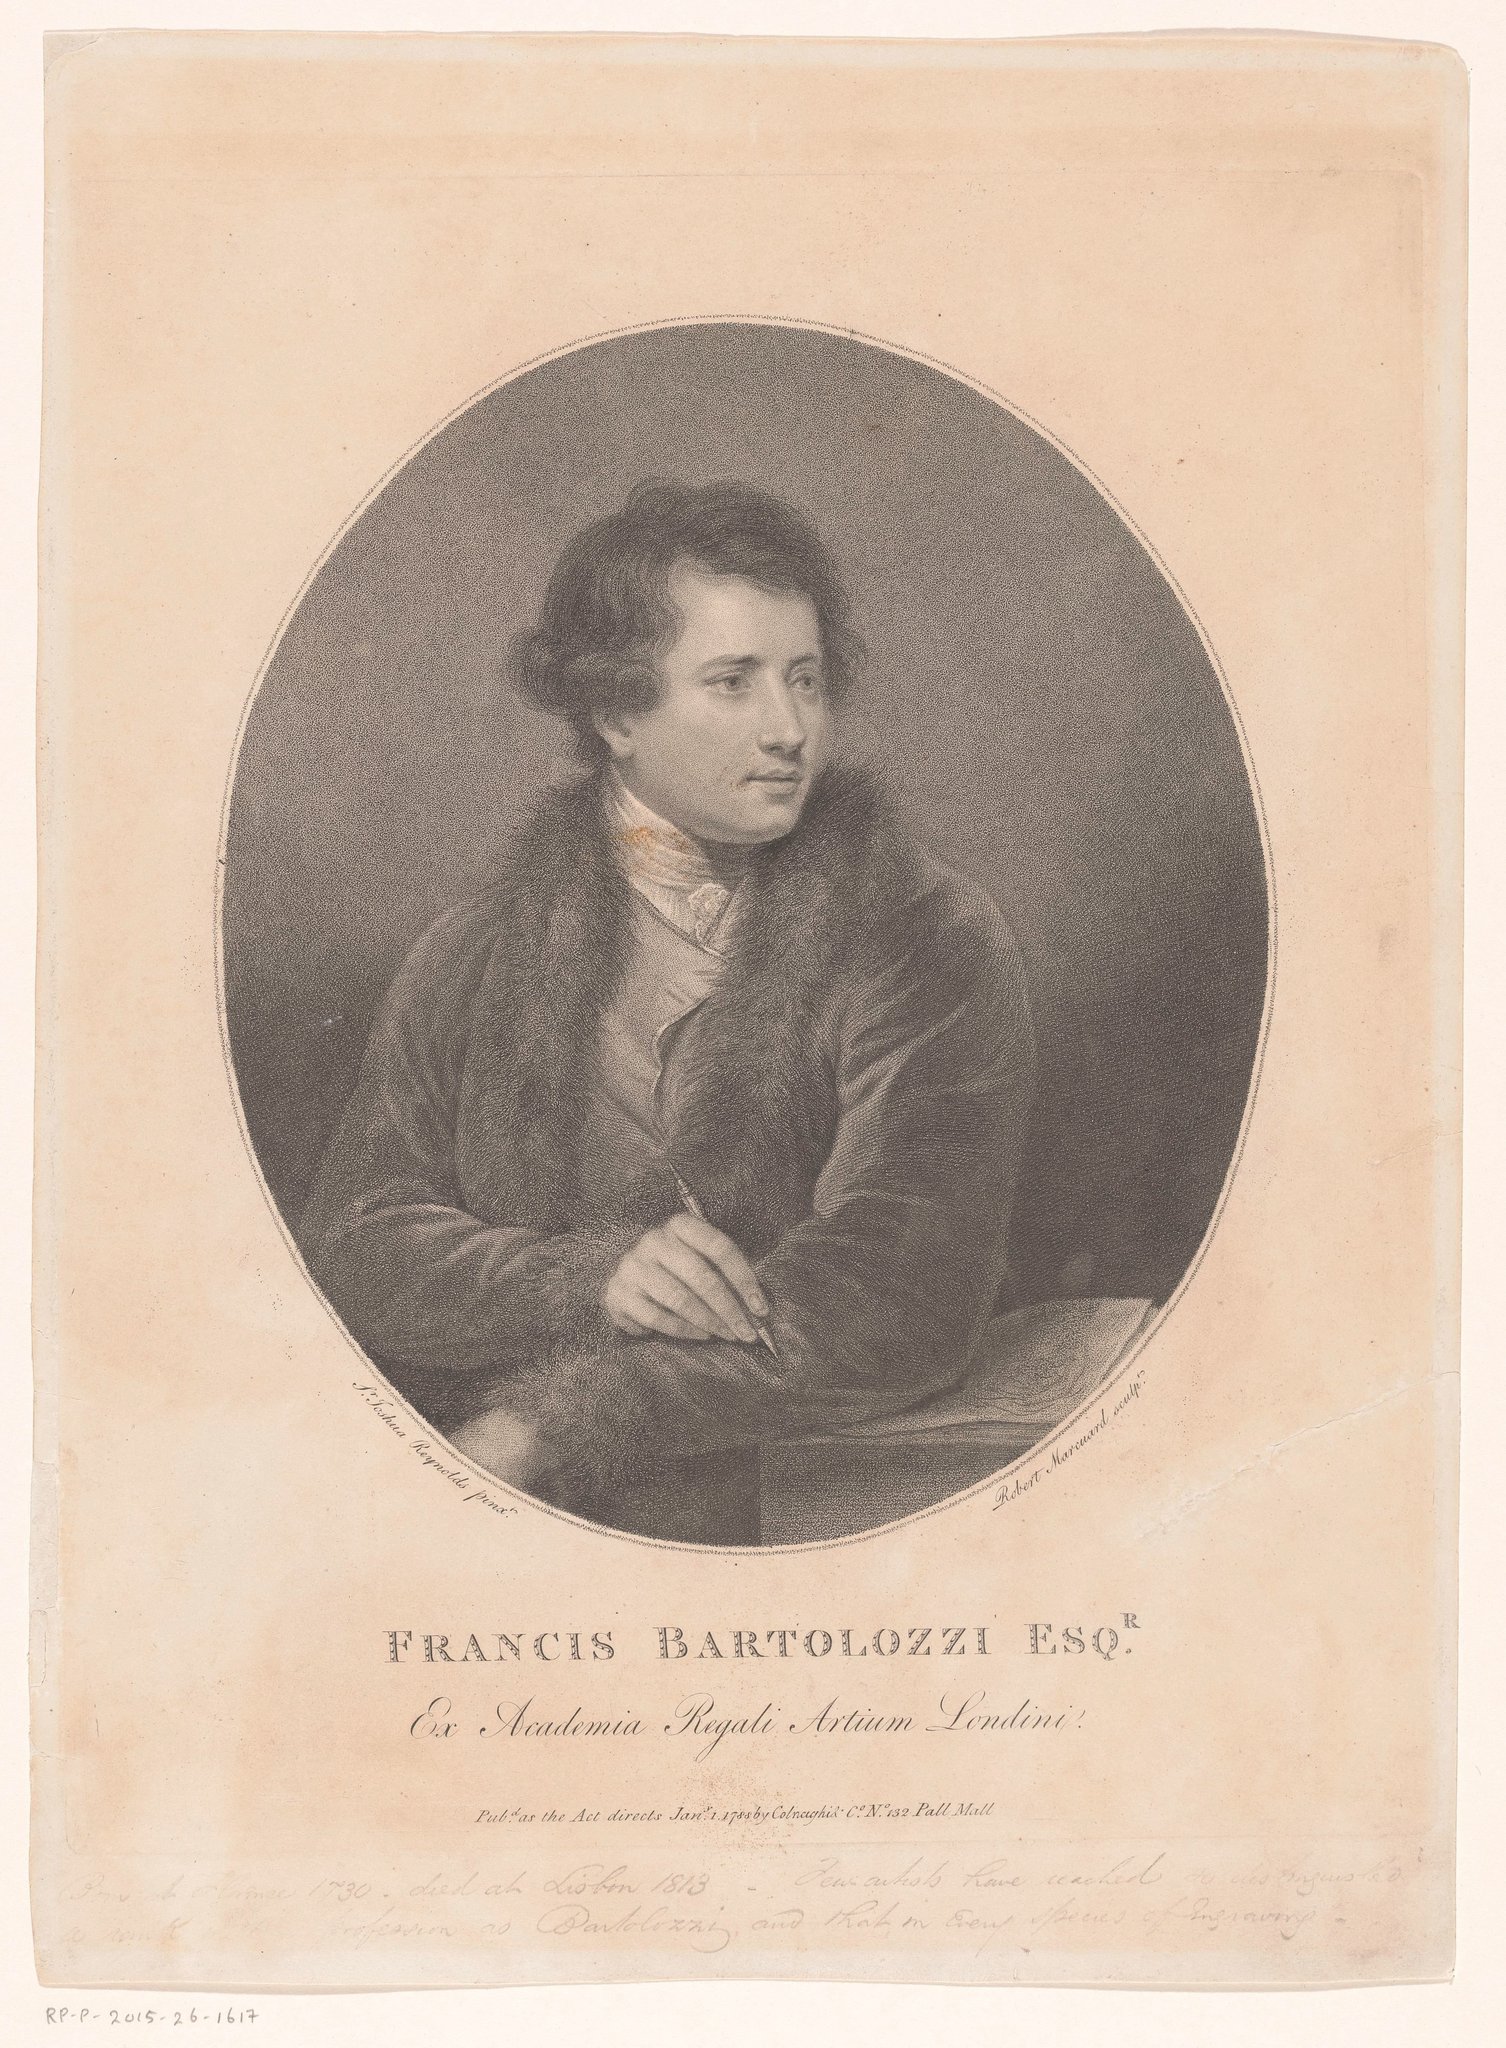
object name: print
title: Portret van prentmaker Francesco Bartolozzi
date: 1701-1788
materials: paper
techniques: etching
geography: london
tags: print maker, draughtsman, publisher, francesco bartolozzi, tools, implements of graphic artist, portrait, self-portrait of graphic artist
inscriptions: collector's mark: Lugt 2228, annotation: ‘Born at Florence 1730 died at Lisbon 1813 - few artists have reached so distinguished / a [...] profession as Bartolozzi and that in every species of engravings’, annotation: ‘Robert Samuel Marcuard an English engraver born in 1751 died in 1792, he was / a pupil of Bartolozzi was considered one of the best of that eminent / master - see Bryan [...] 38.’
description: Portret van Francesco Bartolozzi in een jas met een bontkraag met in zijn rechterhand een etsnaald. Met zijn linker elleboog leunt hij op een tafel met daarop een prent.